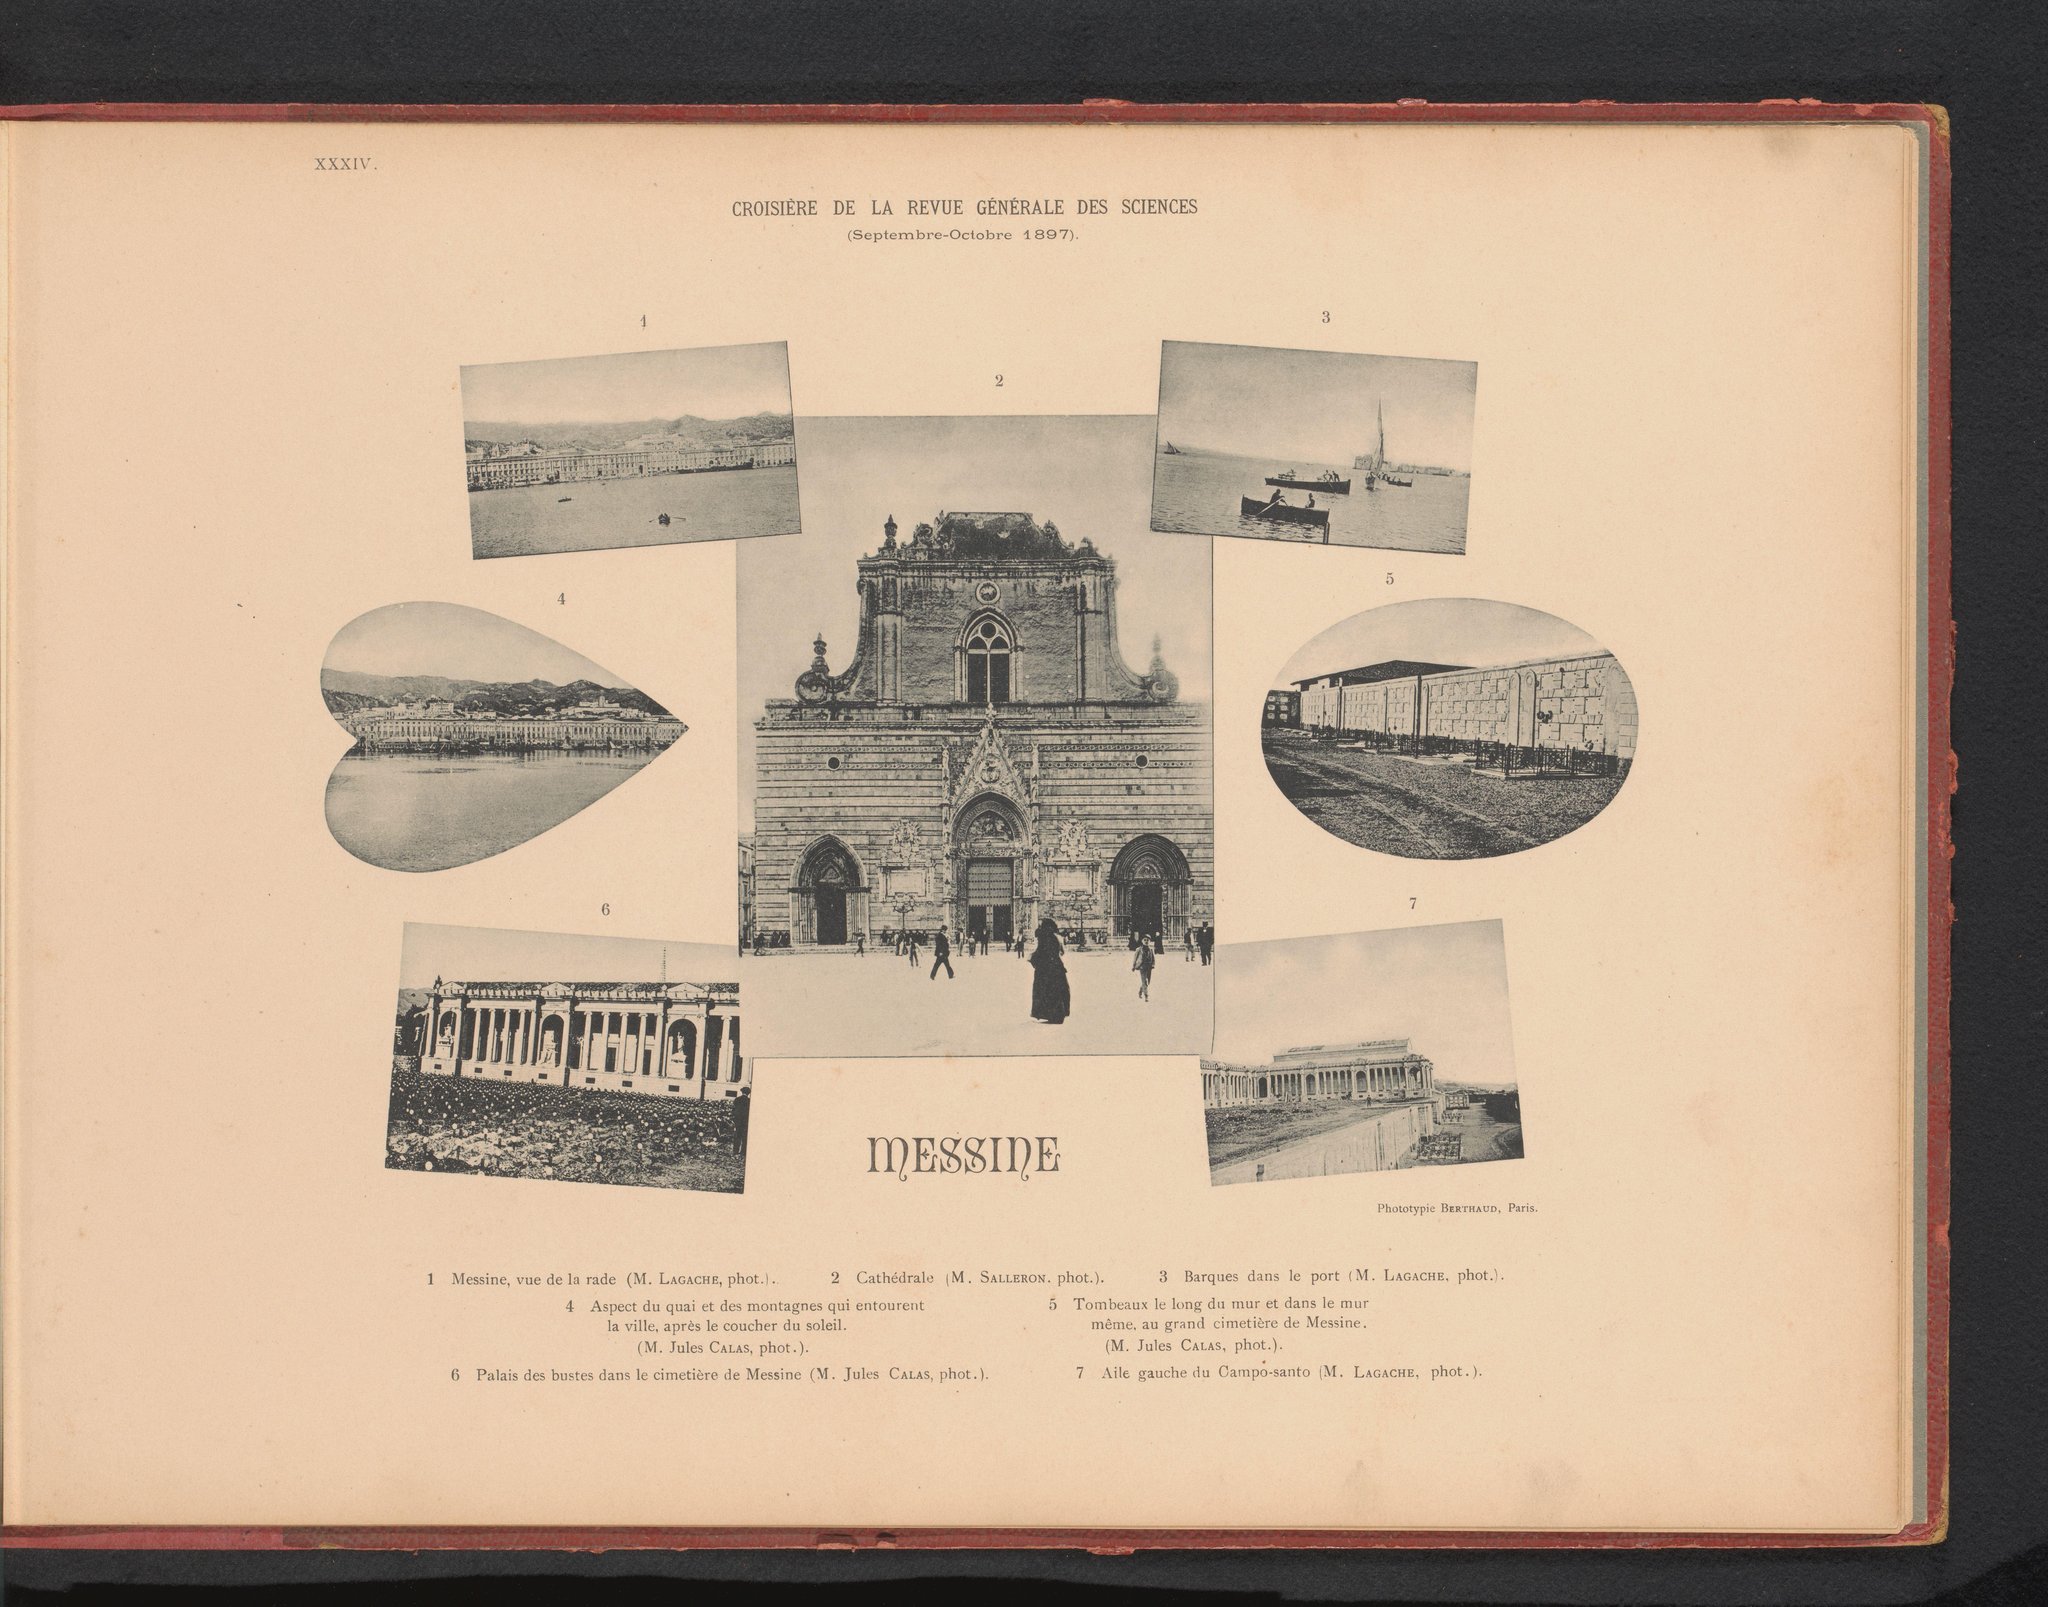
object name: page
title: Messine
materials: paper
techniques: photograph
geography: messina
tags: church (exterior), coast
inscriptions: number: ‘XXXIV.’, inscription: ‘1 Messine, vue de la rade (M. Lagache, phot.). 2 Cathédrale (M. Salleron, phot.). 3 Barques dans le port (M. Lagache, phot.)./ 4 Aspect du quai et des montagnes qui entourent/ la ville, après le coucher du soleil./ (M. Jules Calas, phot.)./ 5 Tombeaux le long du mur et dans le mur/ même, au grand cimetière de Messine./ (M. Jules Calas, phot.)./ 6 Palais des bustes dans le cimetière de Messine (M. Jules Calas, phot.). 7 Aile gauche du Campo-santo (M. Lagache, phot.).’